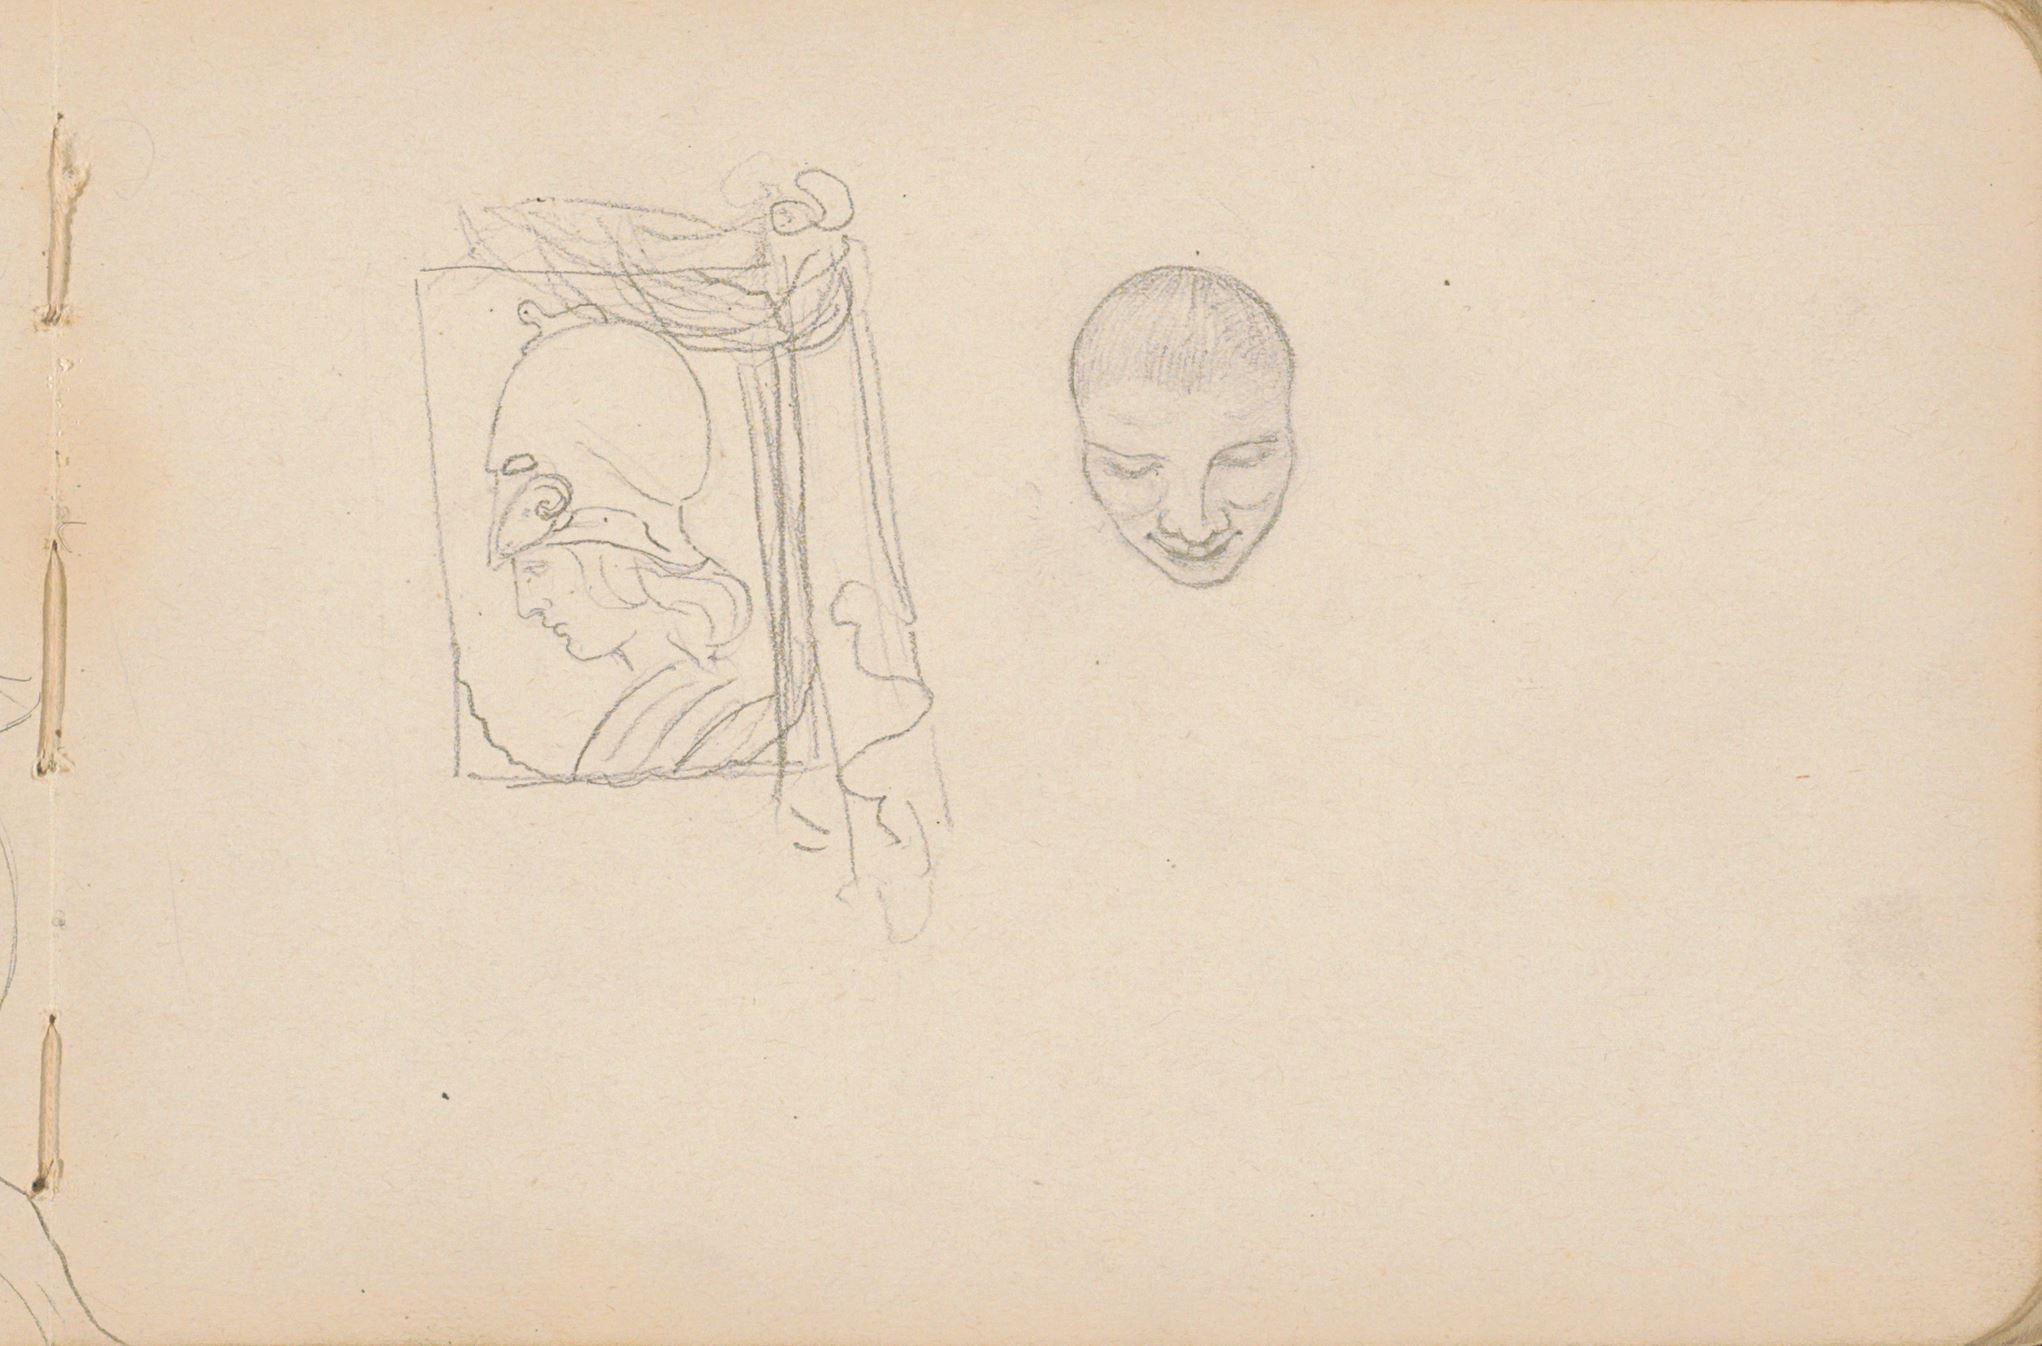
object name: sketchbook leaf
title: Portret van een figuur met een helm, aan de rechterzijde omlijst door een gordijn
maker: julie de graag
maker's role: draughtsman, print maker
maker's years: 1877-1924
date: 1894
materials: paper, pencil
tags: curtains, helmet, head (human)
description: Tevens een studie van een kop. Blad 12 recto uit een schetsboek met 35 bladen.